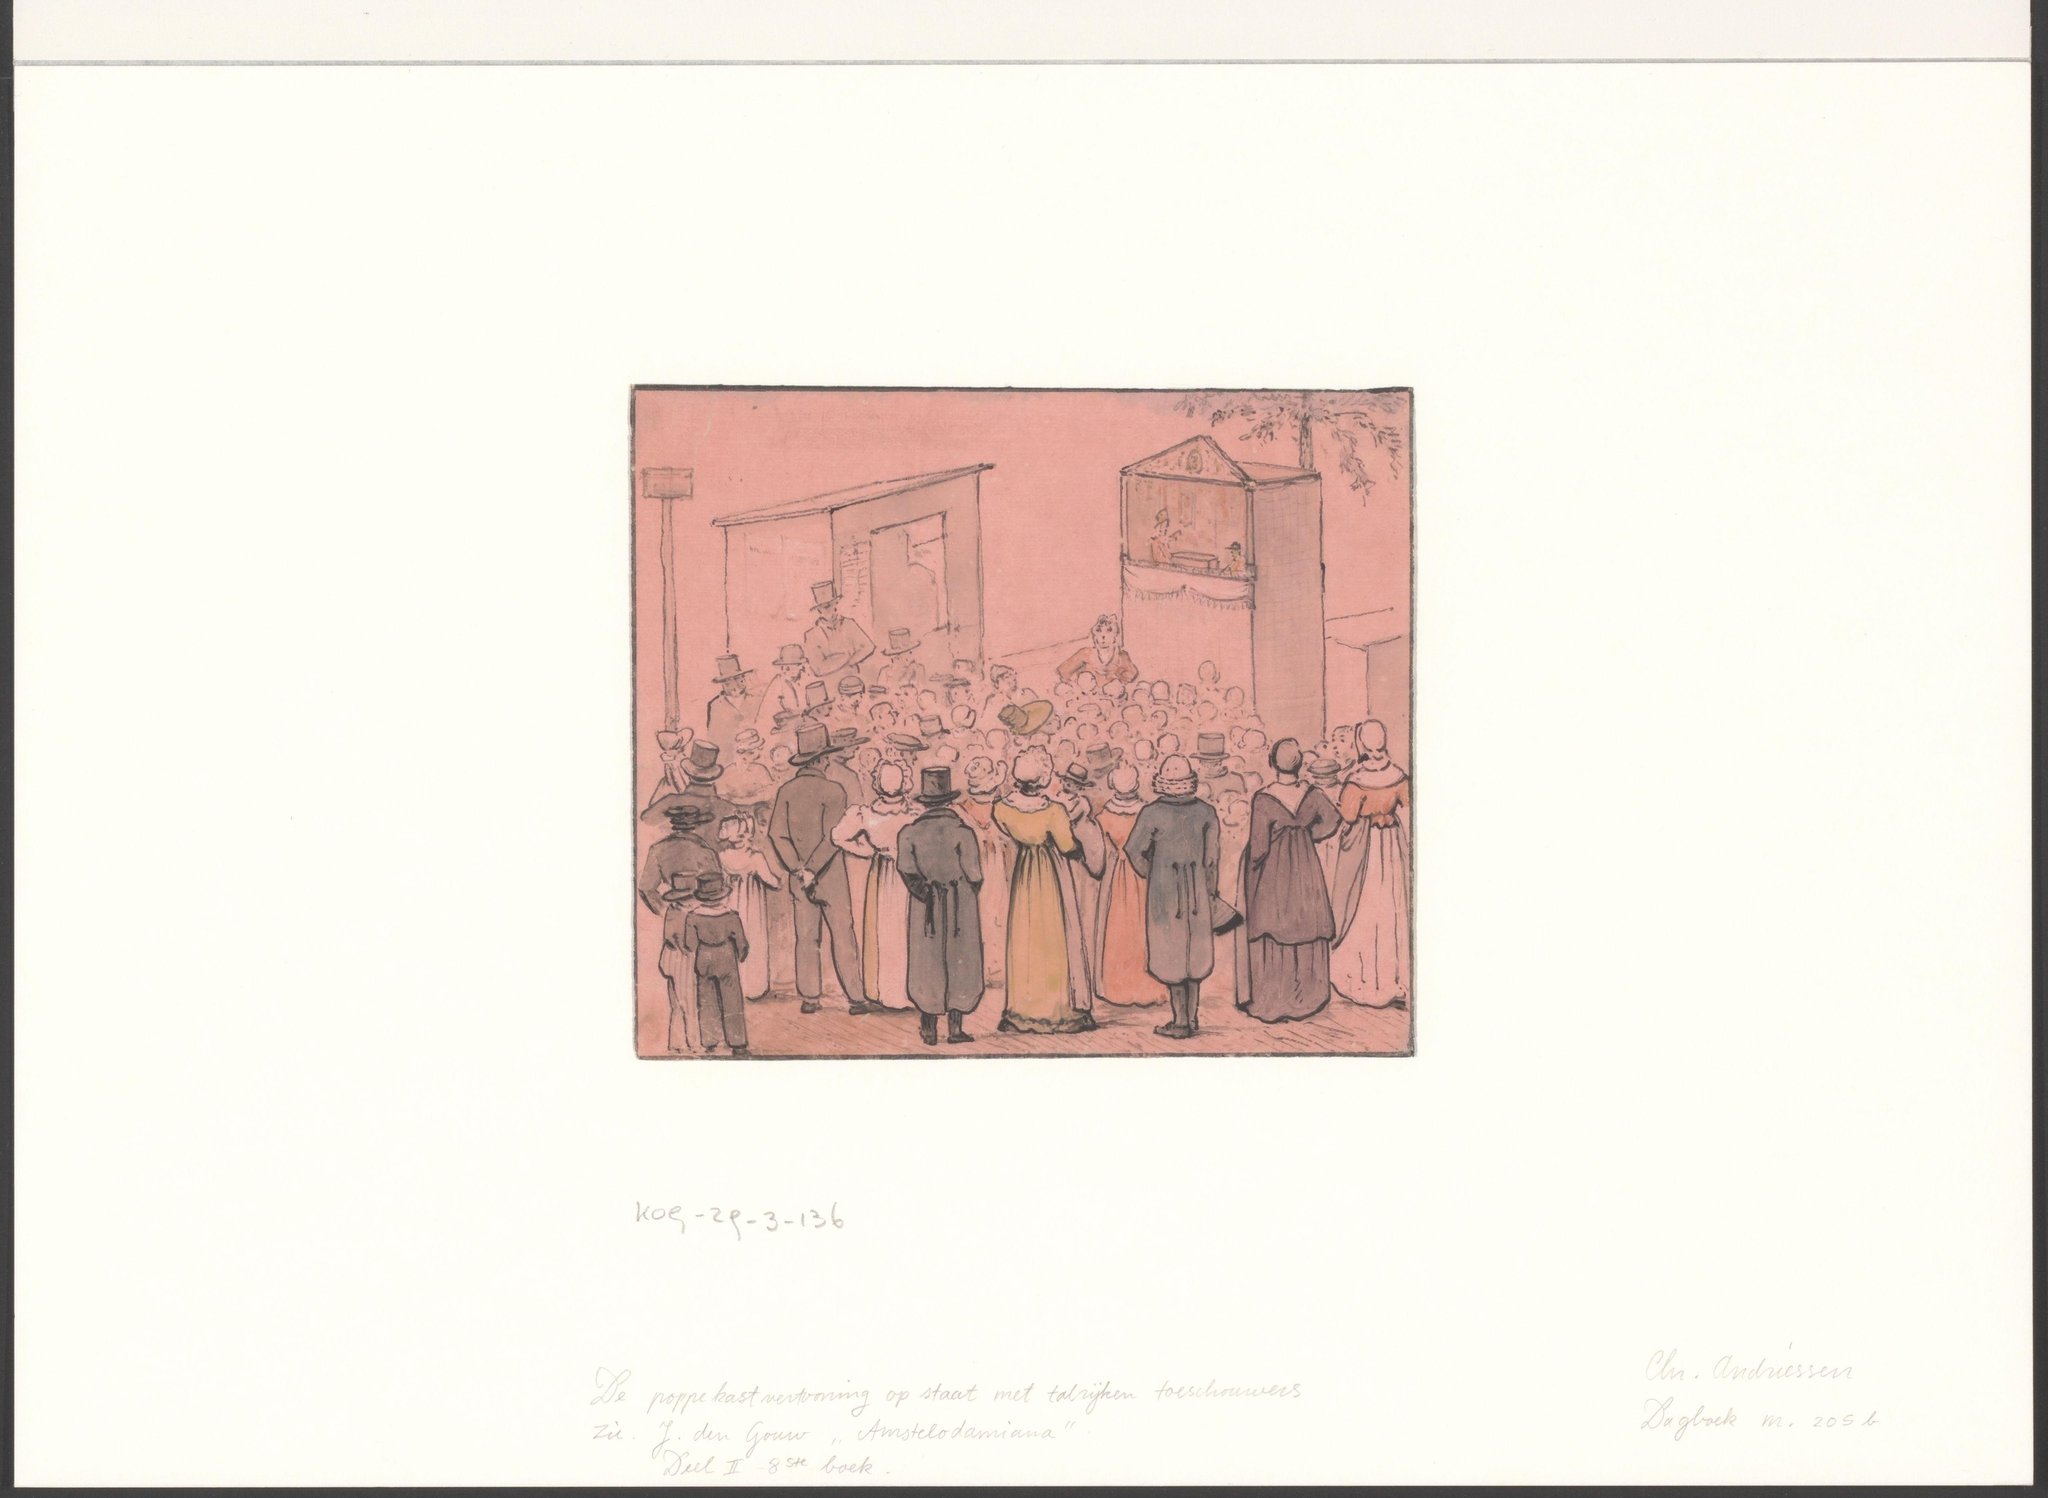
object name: print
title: Poppenkastvoorstelling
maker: christiaan andriessen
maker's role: draughtsman, print maker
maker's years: 1775-1846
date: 1805-1808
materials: ink, paper, watercolor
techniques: brush, pen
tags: puppet, puppet and marionette show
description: Dagboekblad uit het getekende dagboek dat Christiaan Andriessen bijhield van 1805 tot en met 1808.